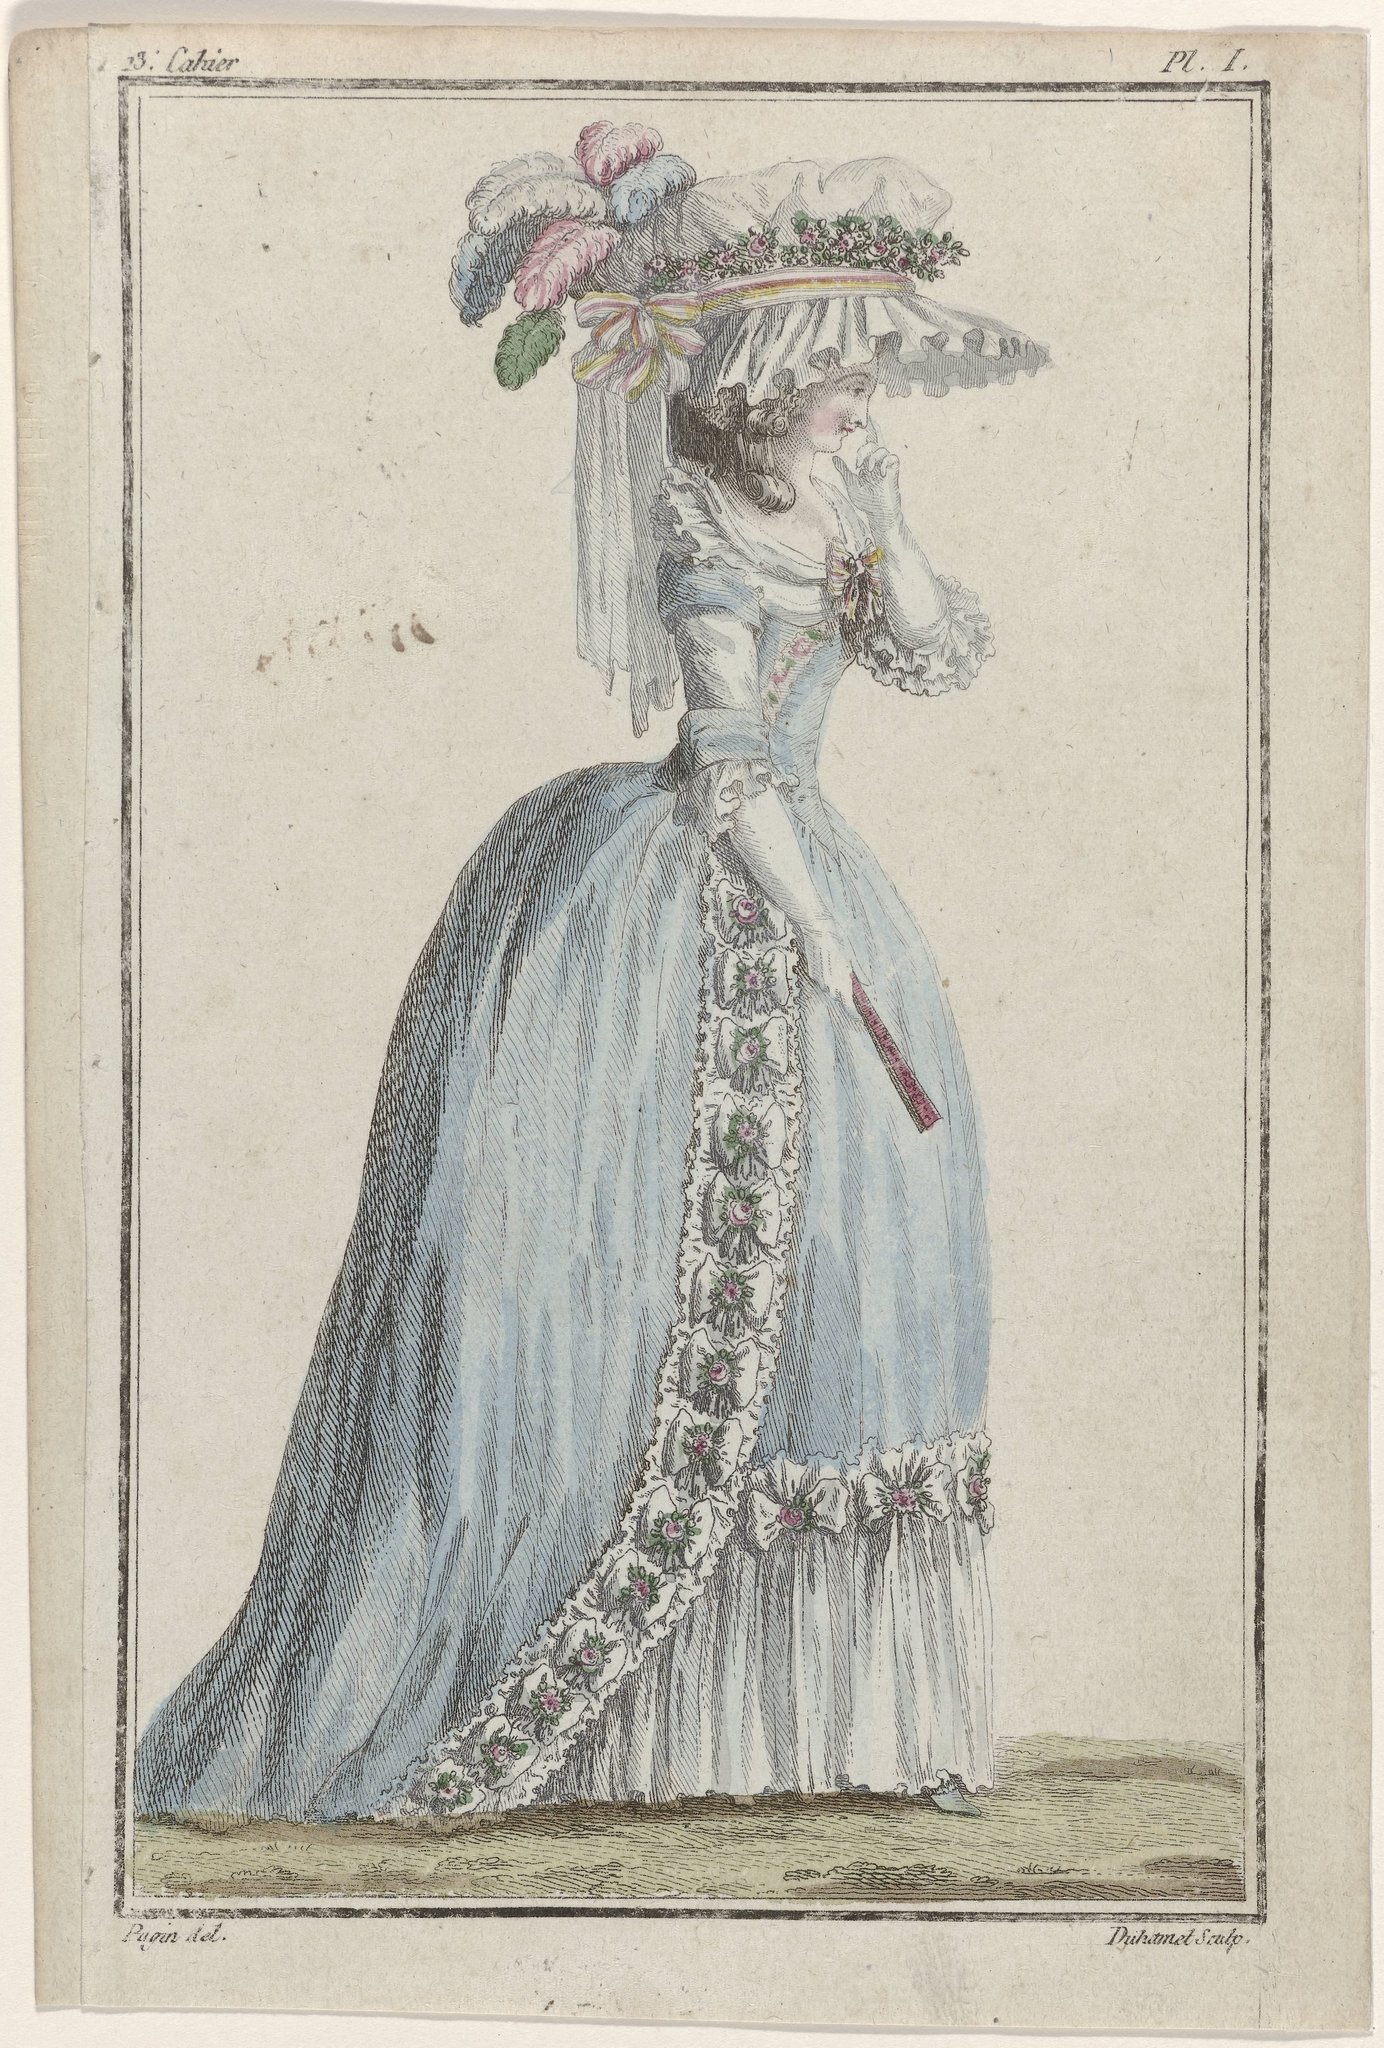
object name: fashion print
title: Cabinet des Modes ou les Modes Nouvelles, 15 mai 1786, Pl. I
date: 1786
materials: paper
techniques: engraving, hand coloring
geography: paris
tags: dress, gown: court gown or court dress (+ women's clothes), gloves, mittens (long gloves) (+ women's clothes), dress, gown (robe à la turque) (+ women's clothes), fashion plates, shoes, sandals (+ women's clothes), fan (+ women's clothes), piece of clothing covering the breast or décolleté (fichu) (+ women's clothes)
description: Vrouw in hofjapon 'à la Turque' van blauwe pékin, versierd met strikken en bloemen. Accessoires: een 'Chapeau-Bonnette', versierd met veren, bloemen en gestreept lint. Lange handschoenen en dichtgevouwen waaier. De prent maakt deel uit van het 13e Cahier uit Cabinet des Modes ou les Modes Nouvelles. De serie bestaat uit 72 modeprenten, uitgegeven door Buisson, Parijs, 15 november 1785 - 1 november 1786.